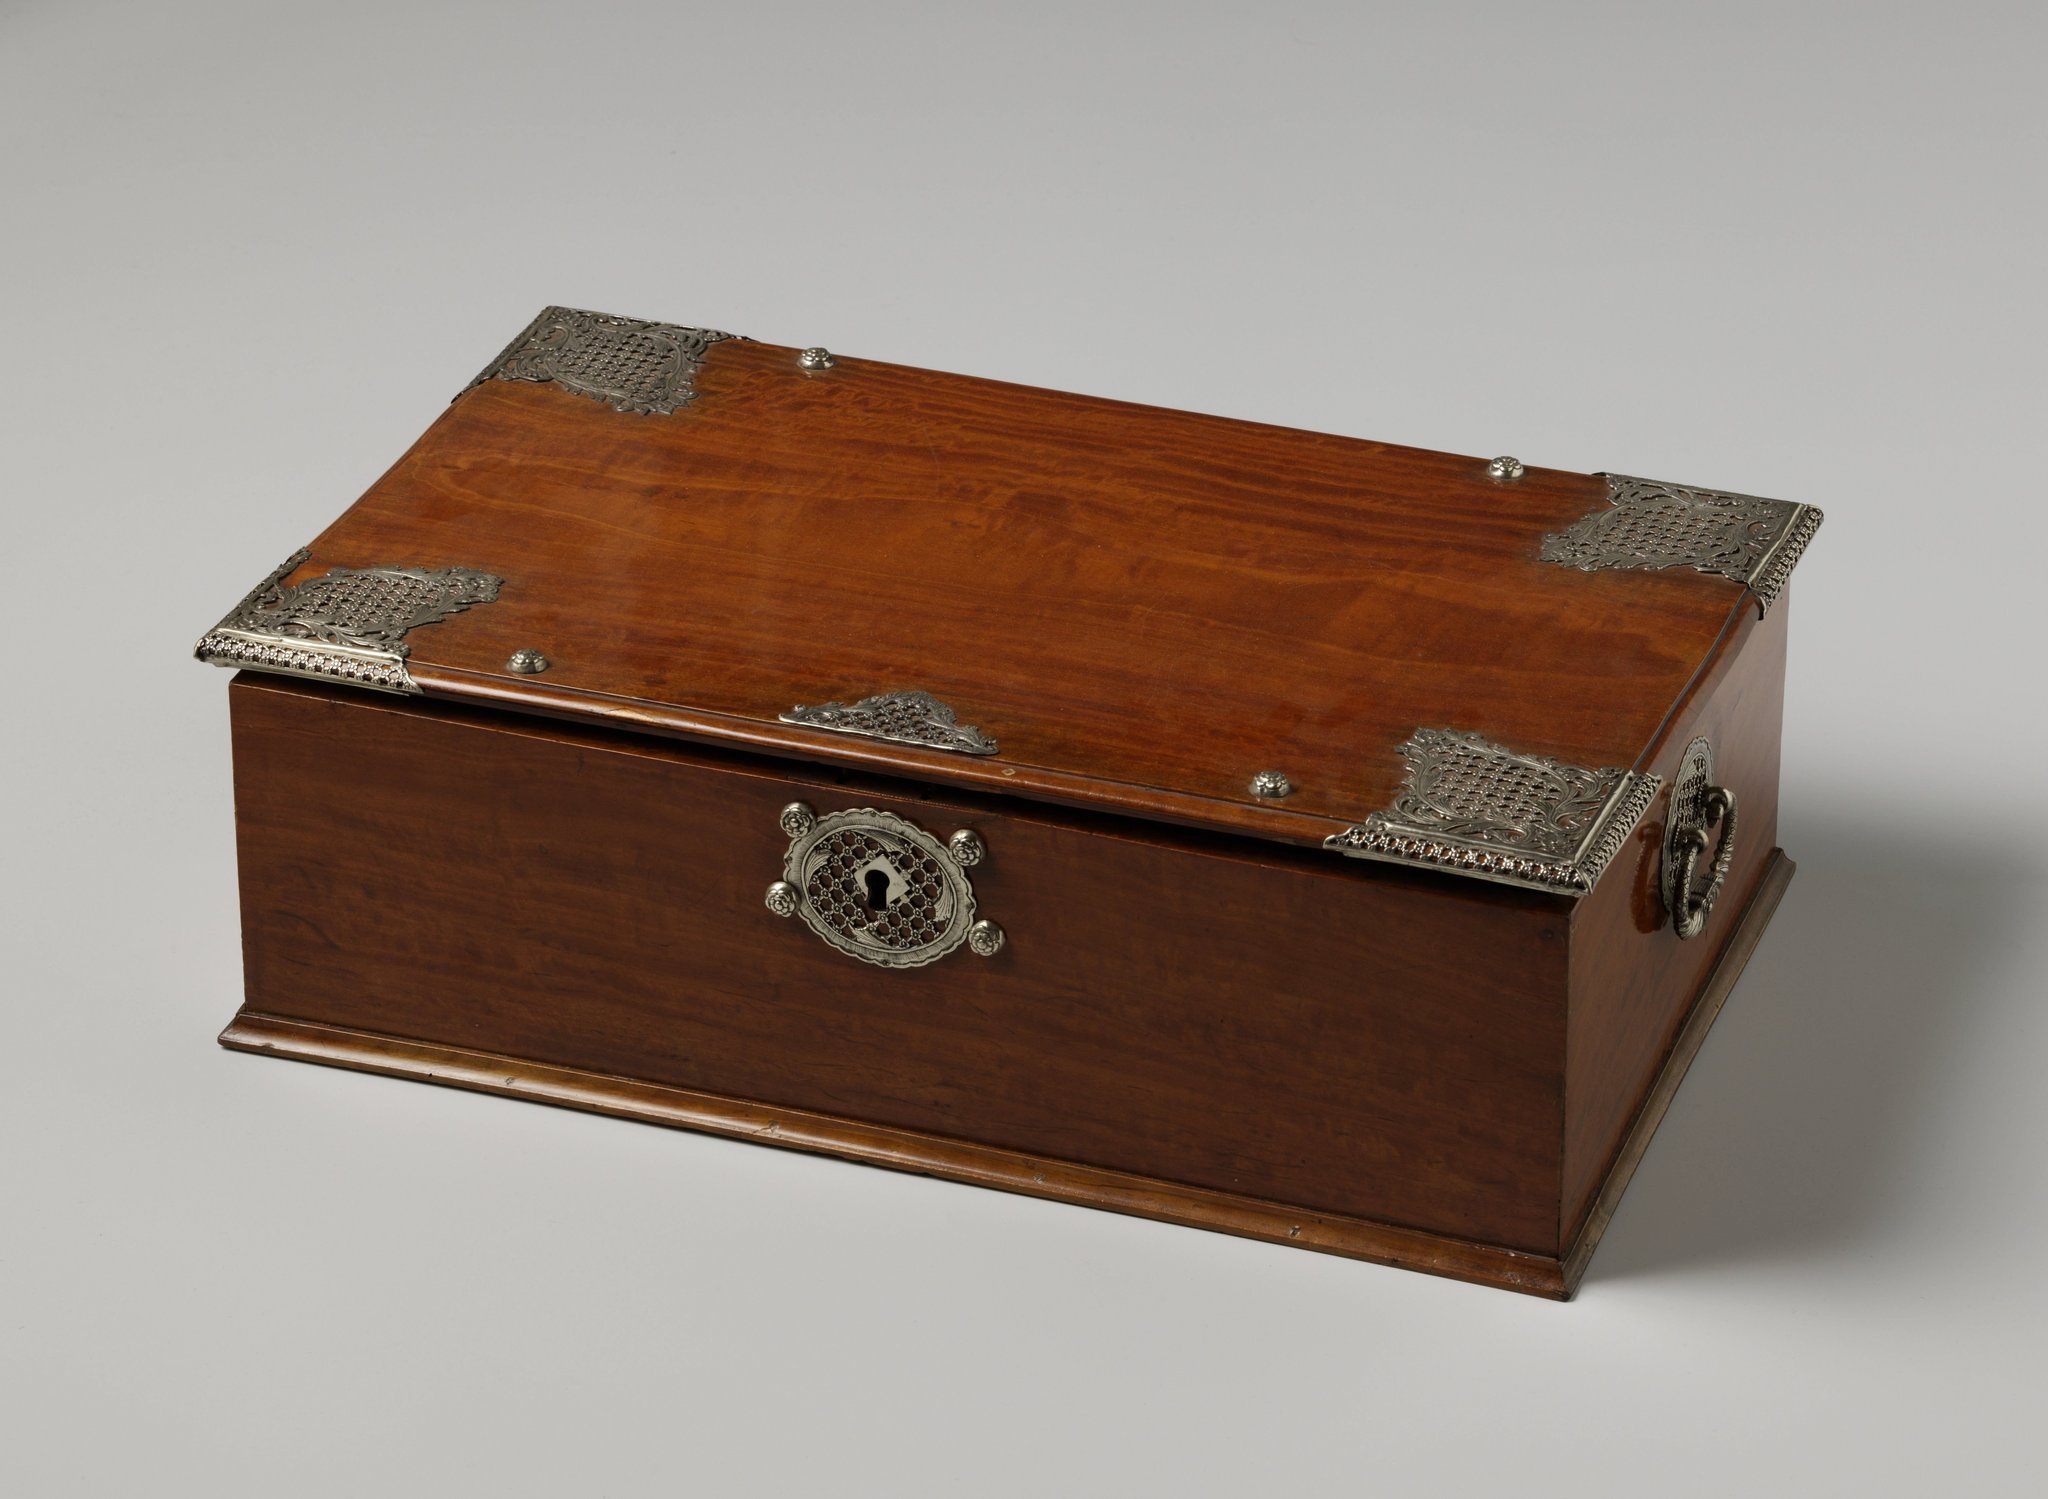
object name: schrijfkist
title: Kist met zilverbeslag met uitneembaar compartiment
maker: Anonymous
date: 1775-1799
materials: wood, silver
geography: indonesia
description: Schrijfkist van satijnhout met geciseleerd, gegoten, zilveren beslag met rocaillemoteiven. Het inwendige is ingedeeld in een holle ruimte, aan de bovenzijde afgesloten door een uitneembare binnendoos. Deze laatste is onderverdeeld in een groot middenvak en twee smalle kleine vakken. Deze drie ruimten zijn afgedekt met drie invallende deksels die eveneens van bewerkt zilveren beslag zijn voorzien.